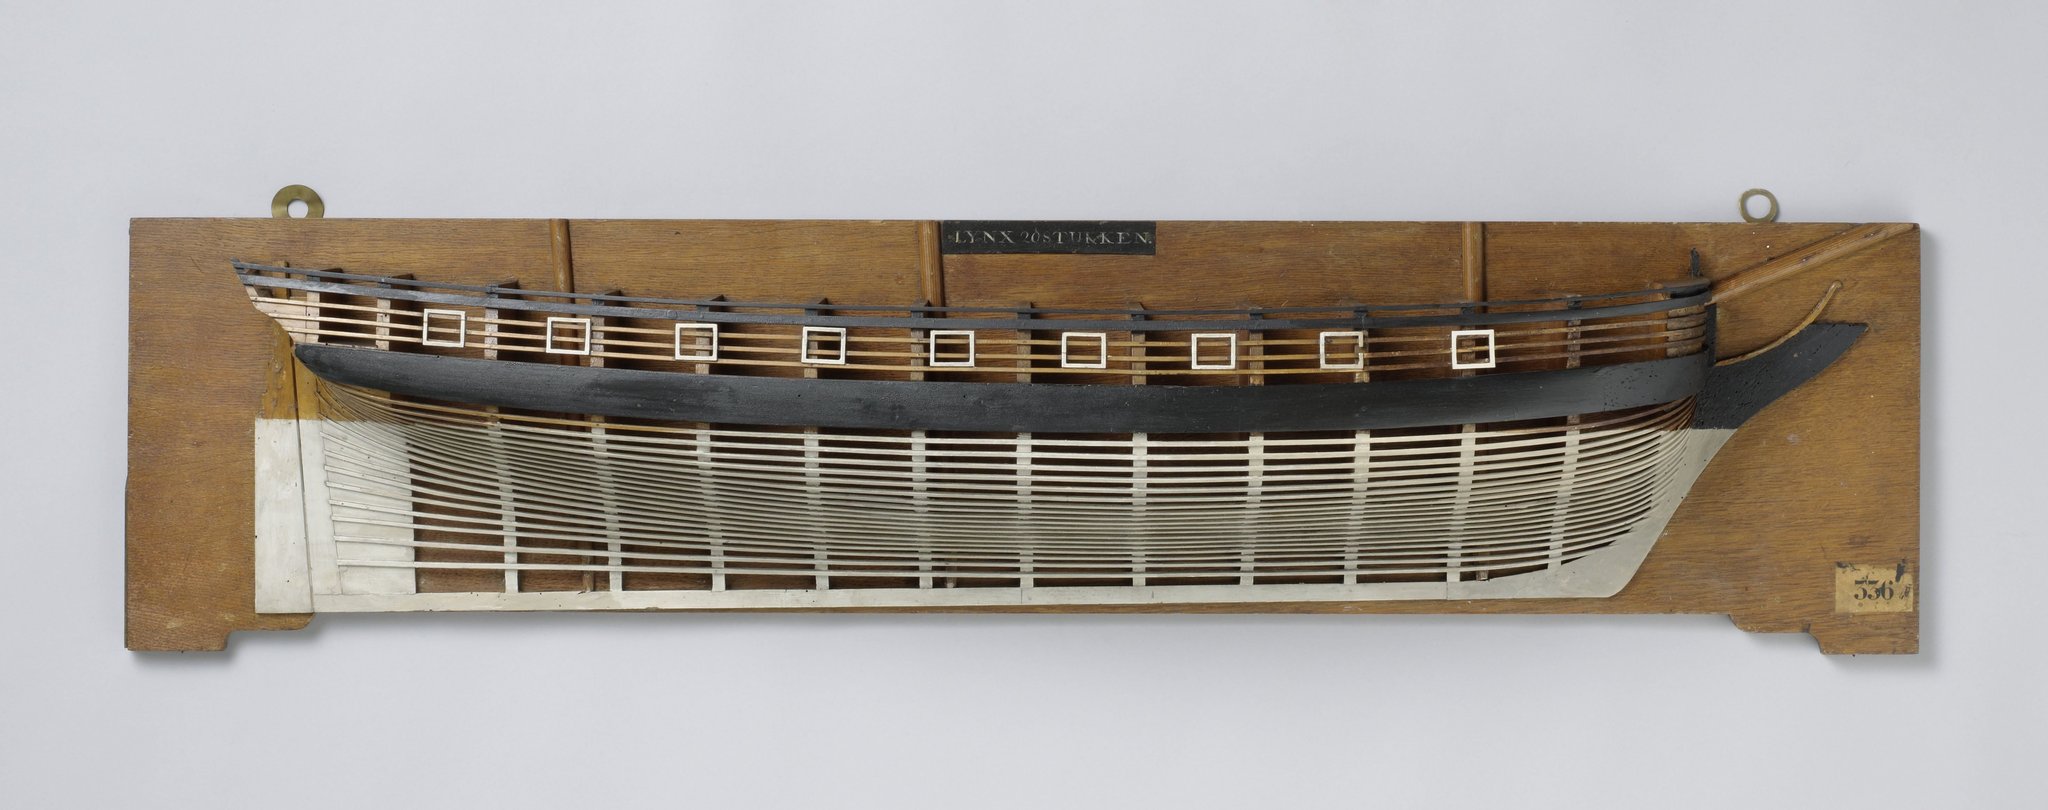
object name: builder's model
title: Half Model of an 18-Gun Sloop of War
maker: Anonymous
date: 1806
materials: wood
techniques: polychromy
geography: amsterdam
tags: lynx (schip)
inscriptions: inscription, top centre, on a rectangular black label: ‘LYNX 20 STUKKEN.’, label, bottom right: ‘336’ former inventory label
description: De historische informatie over de Lynx is verwarrend. Er zijn twee korvetten met die naam geweest, één van 20 stukken gebouwd door P. Glavimans Jz. in Rotterdam in 1806 (zusterschip van de Venus, zie NG-MC-336-1), en één van 28 stukken gebouwd door P. Schuijt Jr. in Amsterdam in 1816-1818. Het is ook mogelijk dat het model de brik Lynx van 18 stukken voorstelt, gebouwd in Vlissingen in 1838.